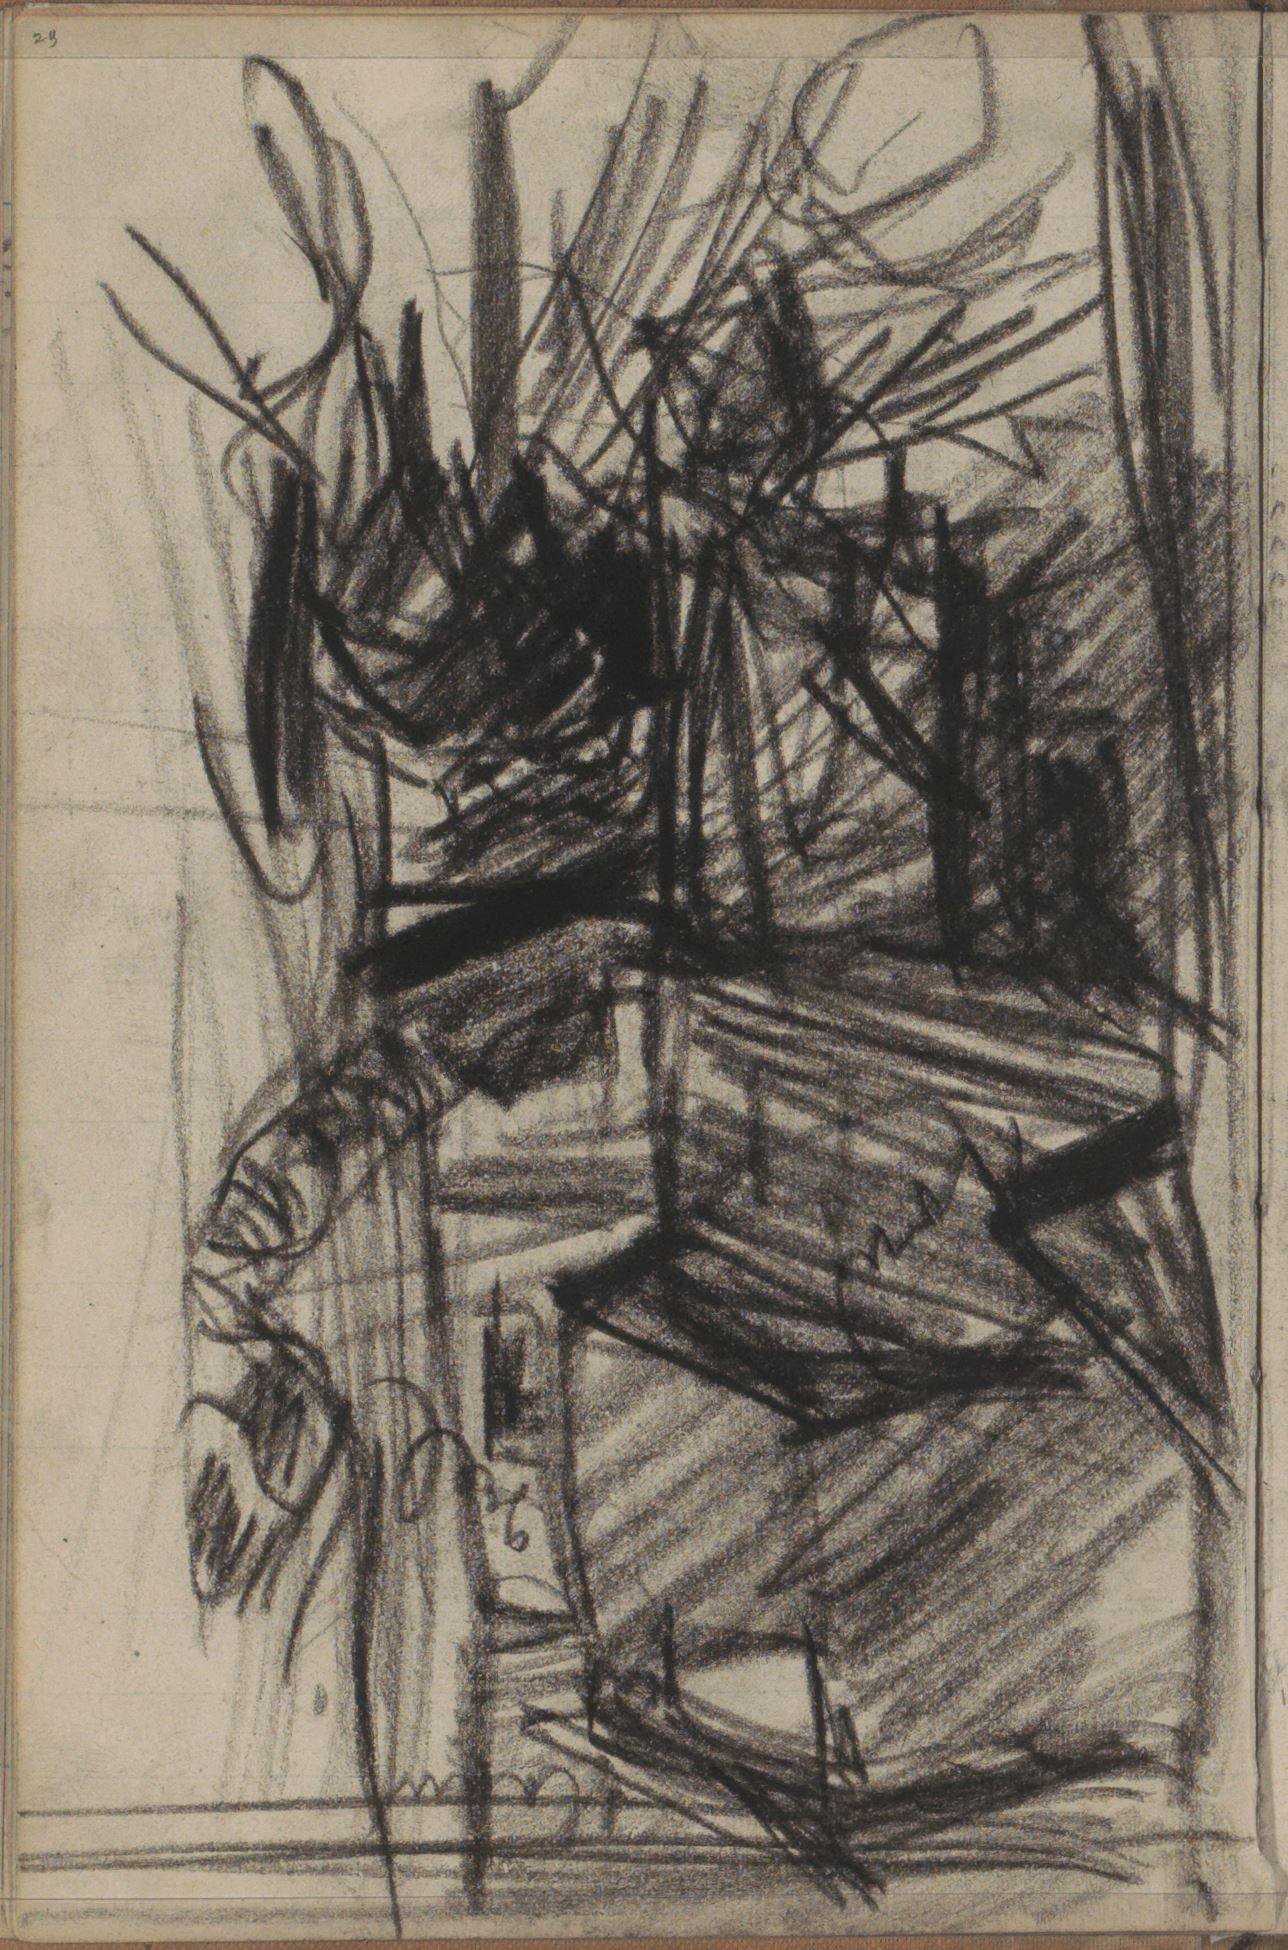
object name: sketchbook leaf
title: Architectuurstudie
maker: marius bauer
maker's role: draughtsman, print maker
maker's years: 1867-1932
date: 1888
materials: chalk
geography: istanbul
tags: architecture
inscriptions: kleurnotitie, handgeschreven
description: Mogelijk een huis in een straat. Pagina 29 uit een schetsboek met 56 bladen.